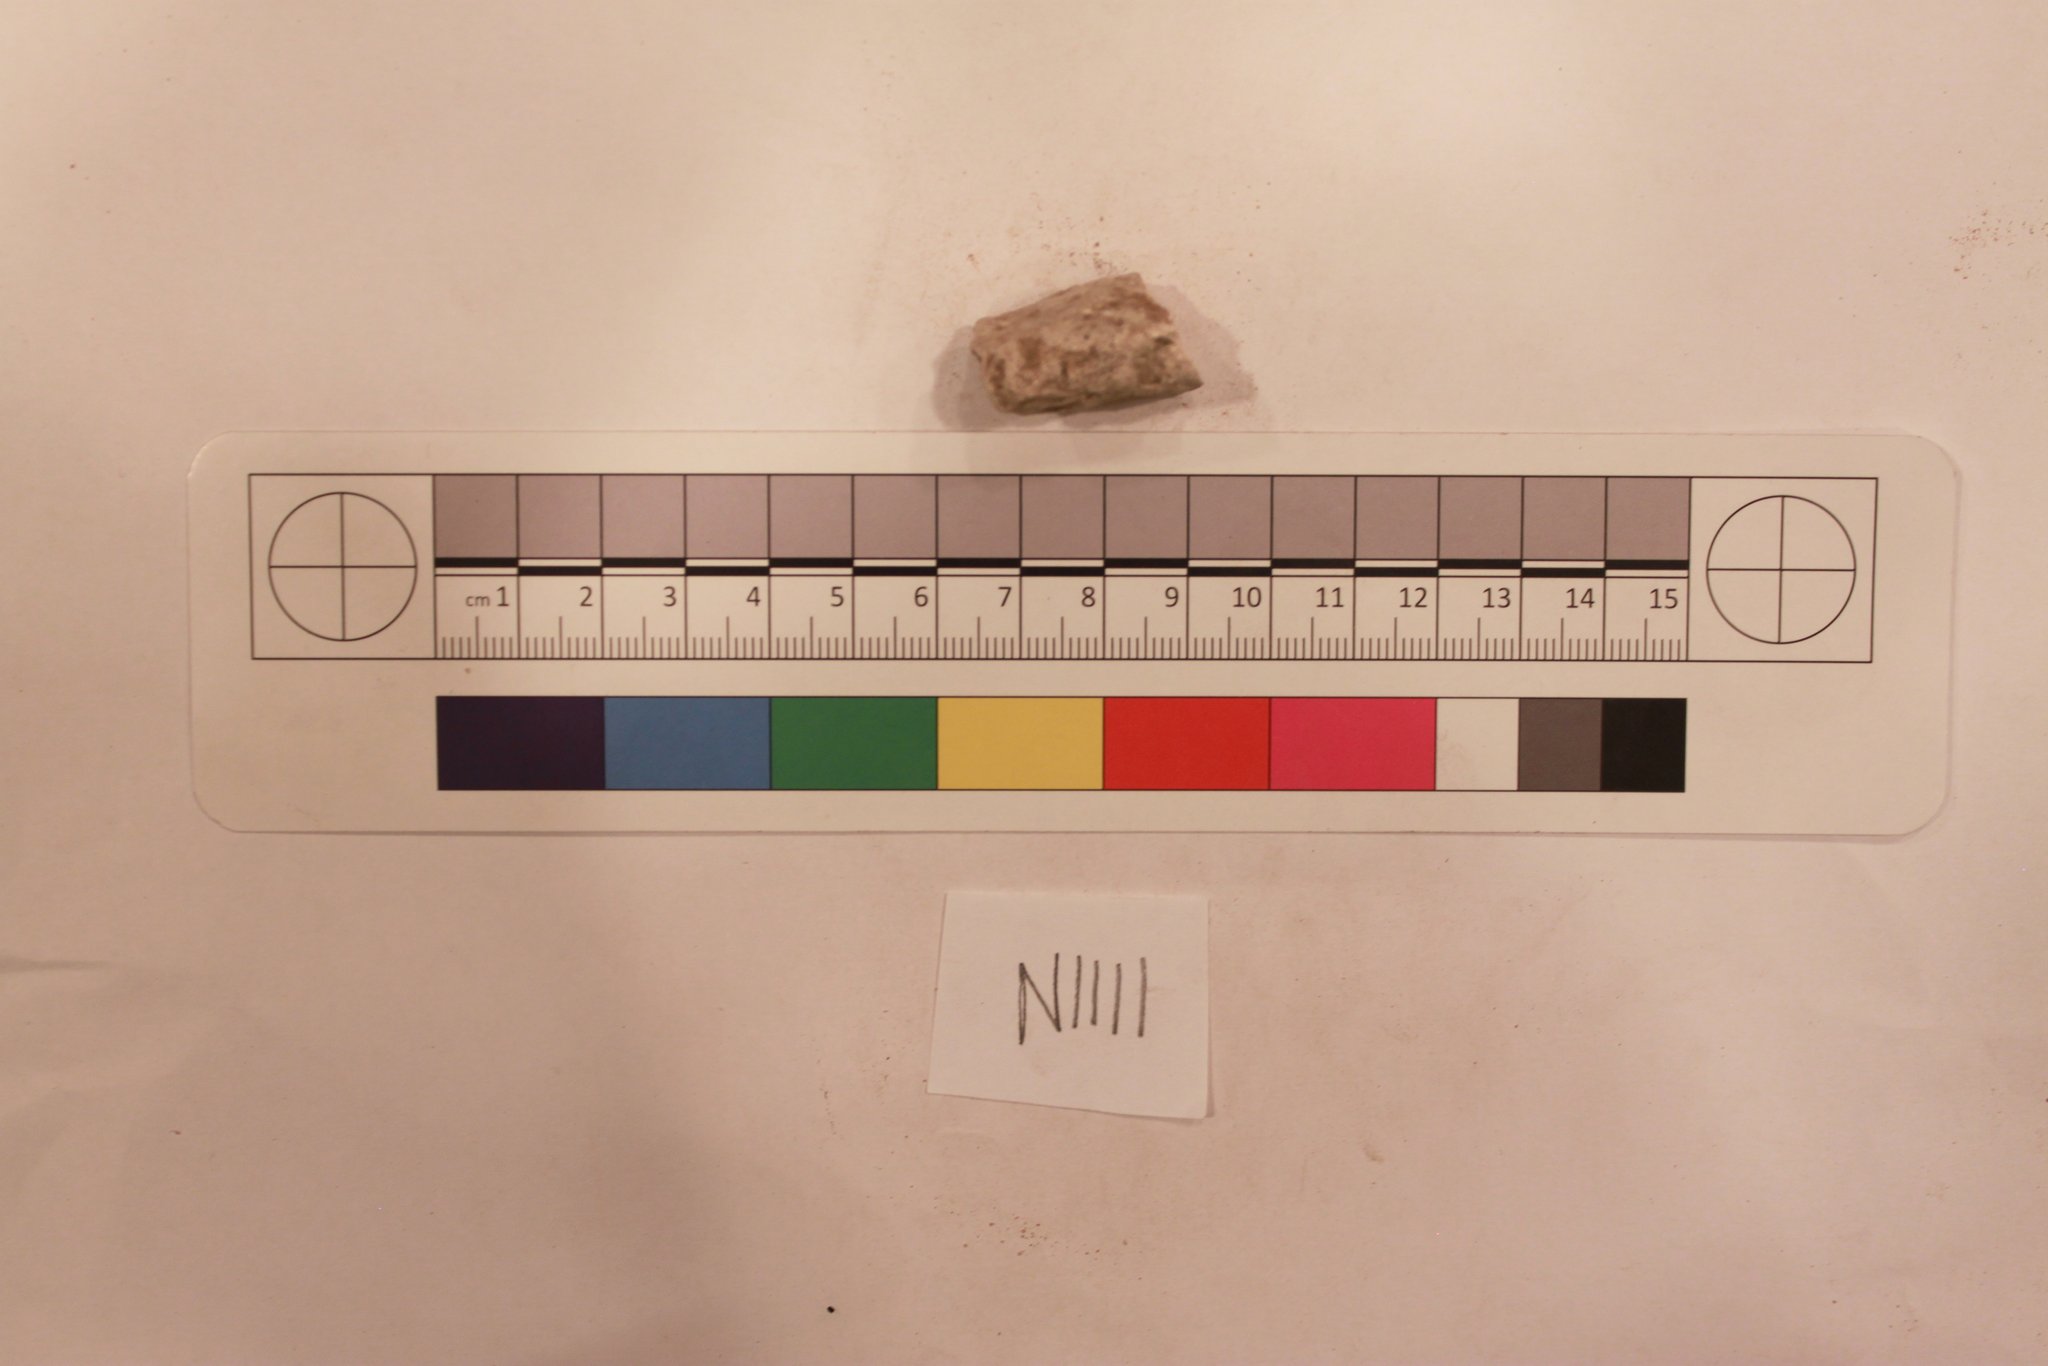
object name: fragment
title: Stucco Fragment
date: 701-1200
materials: plaster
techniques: carving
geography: iran